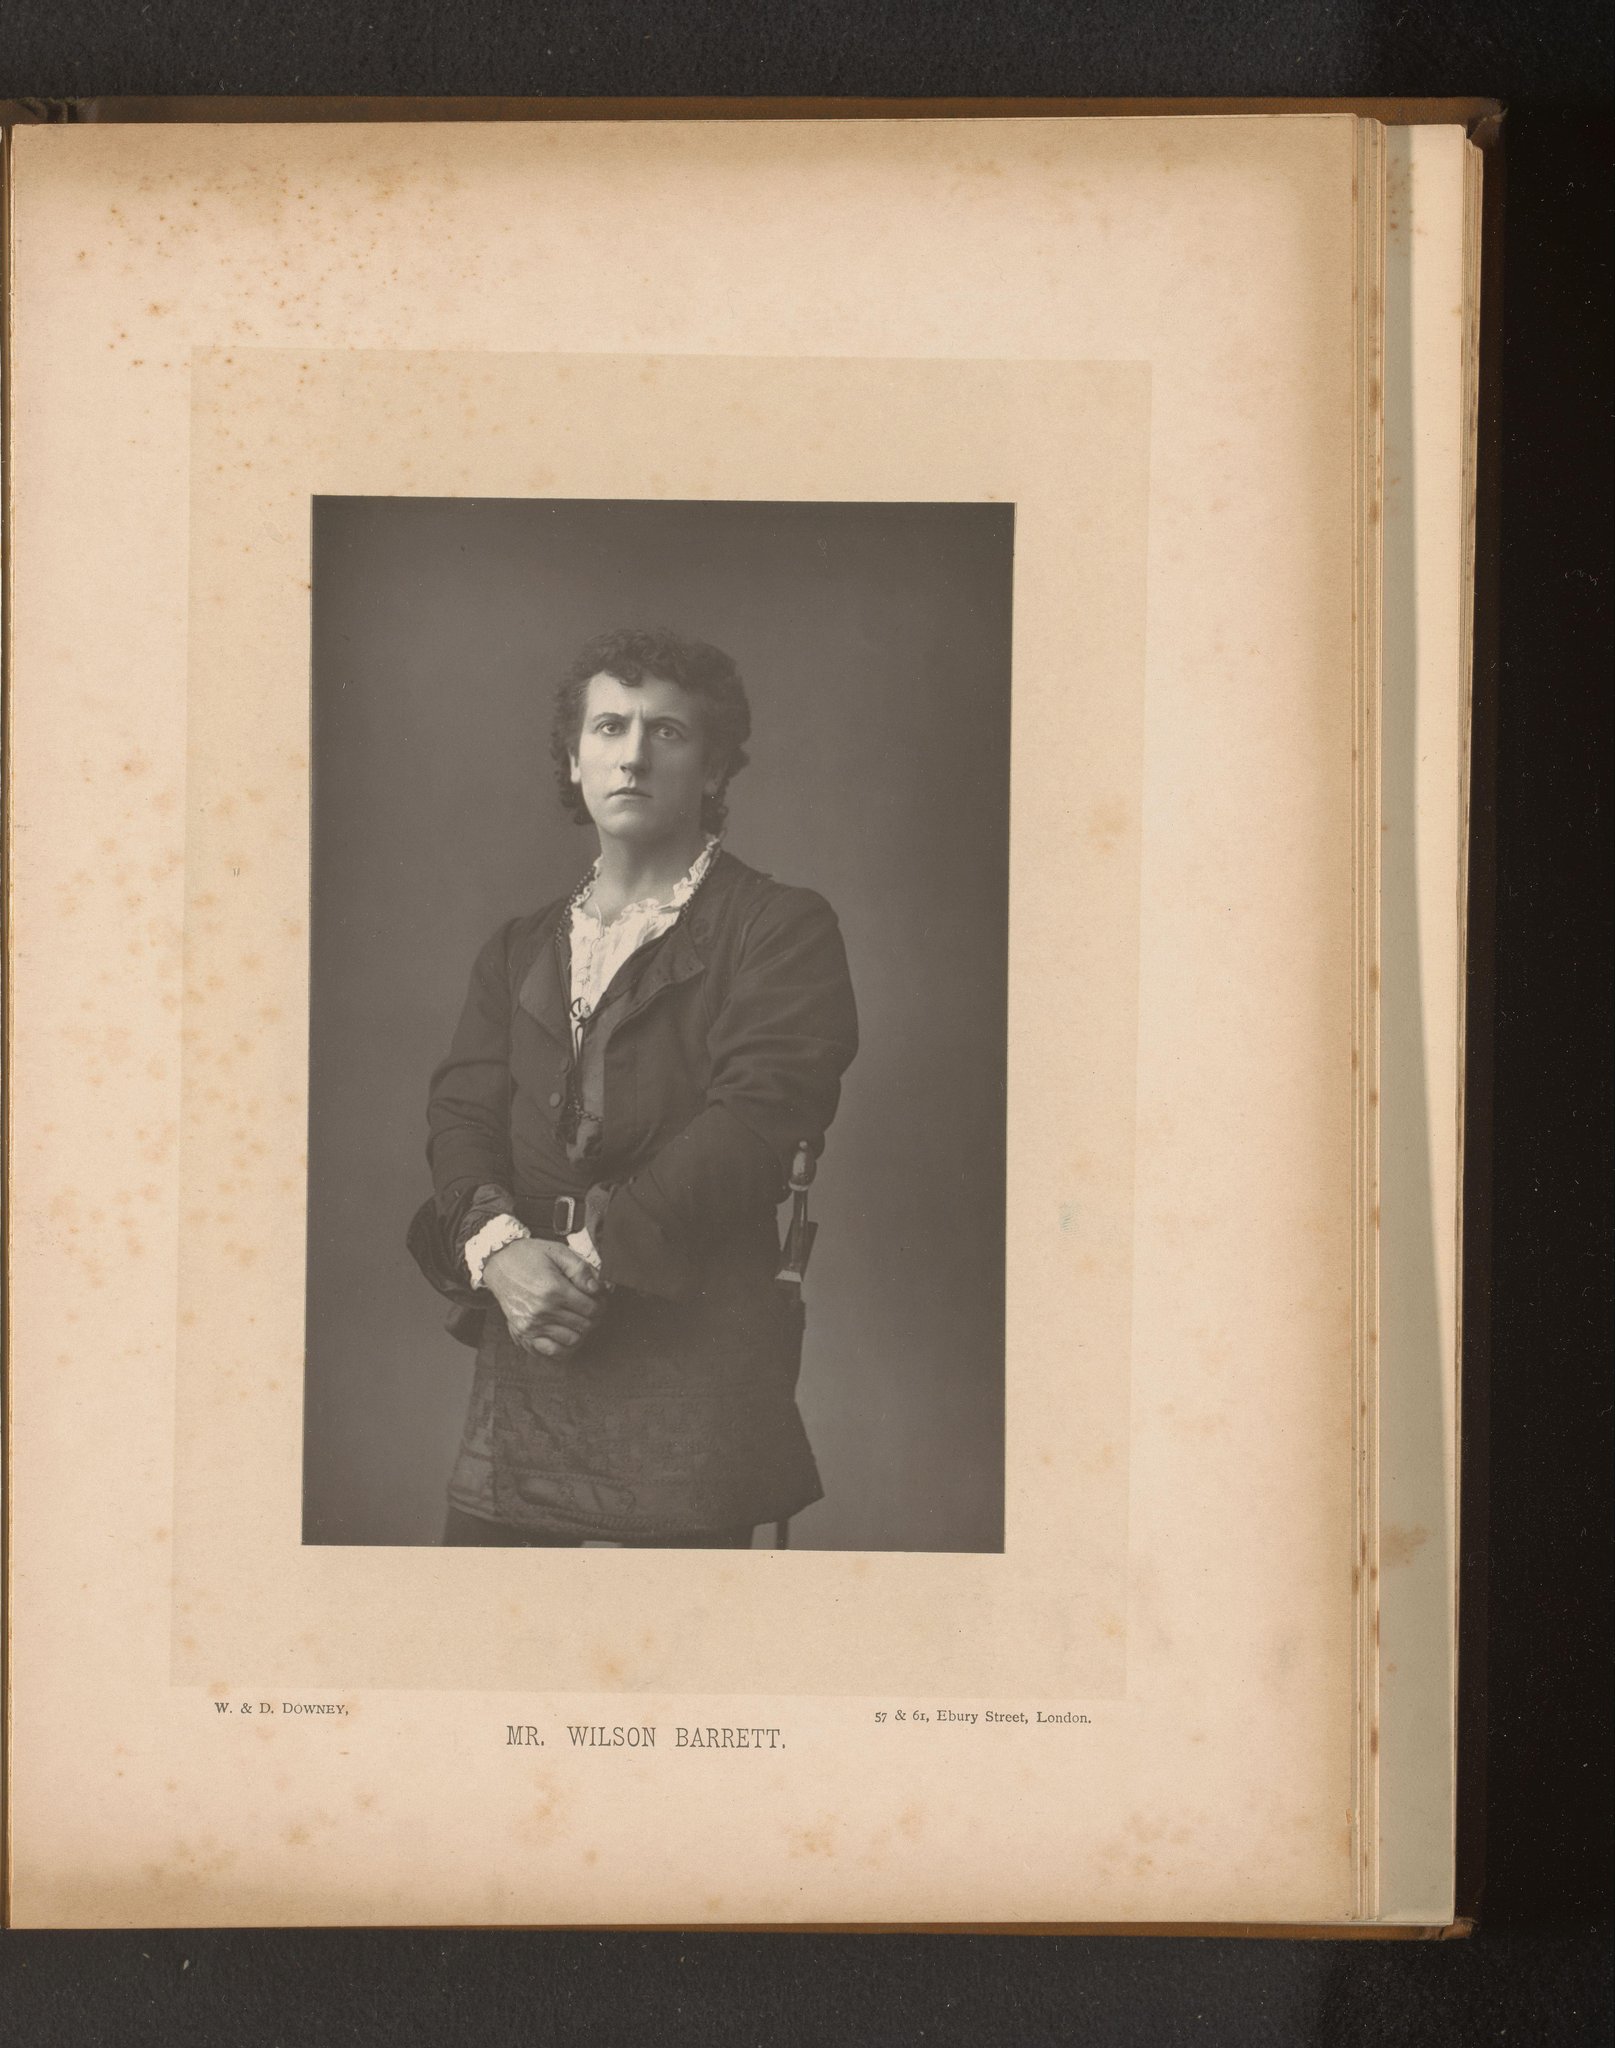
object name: photomechanical print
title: Portret van Wilson Barrett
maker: Anonymous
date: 1881-1891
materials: paper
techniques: woodburytype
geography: london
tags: portrait of actor, actress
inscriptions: inscription: ‘57 & 61, Elbury Street, London.’